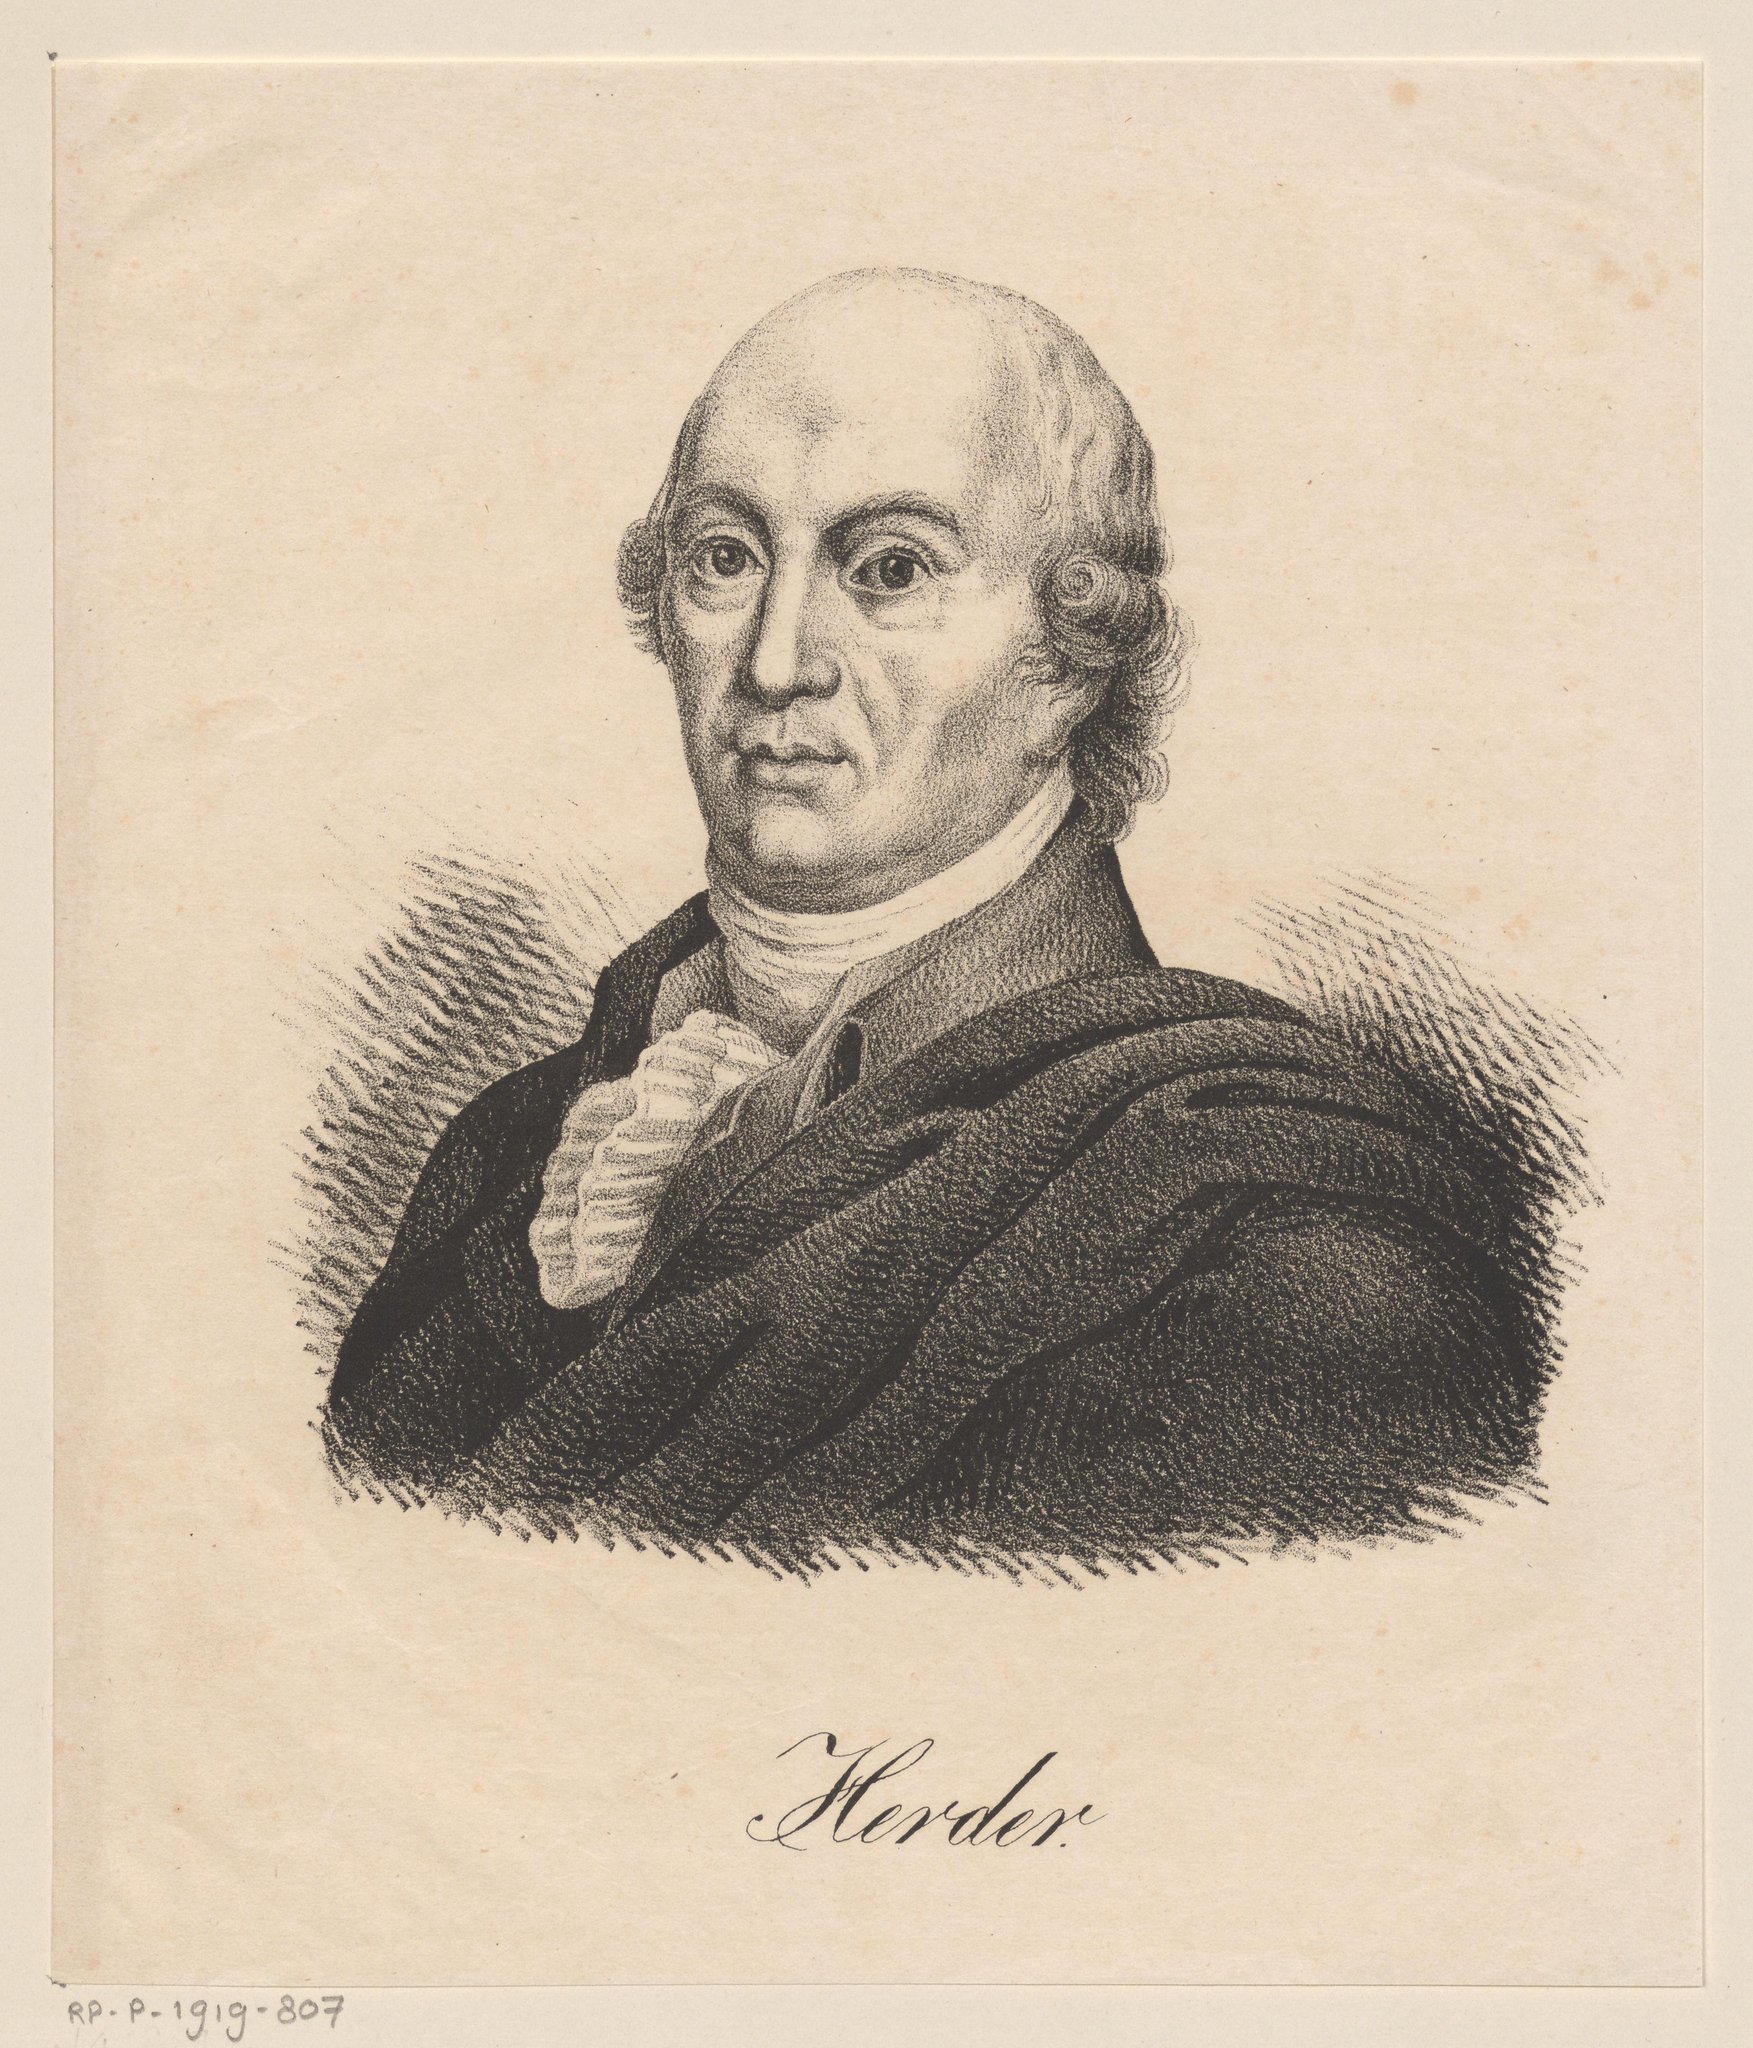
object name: print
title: Portret van Johann Gottfried von Herder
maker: Anonymous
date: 1825-1874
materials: paper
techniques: lithograph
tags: historical persons, writer, poet, author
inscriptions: collector's mark: Lugt 2228